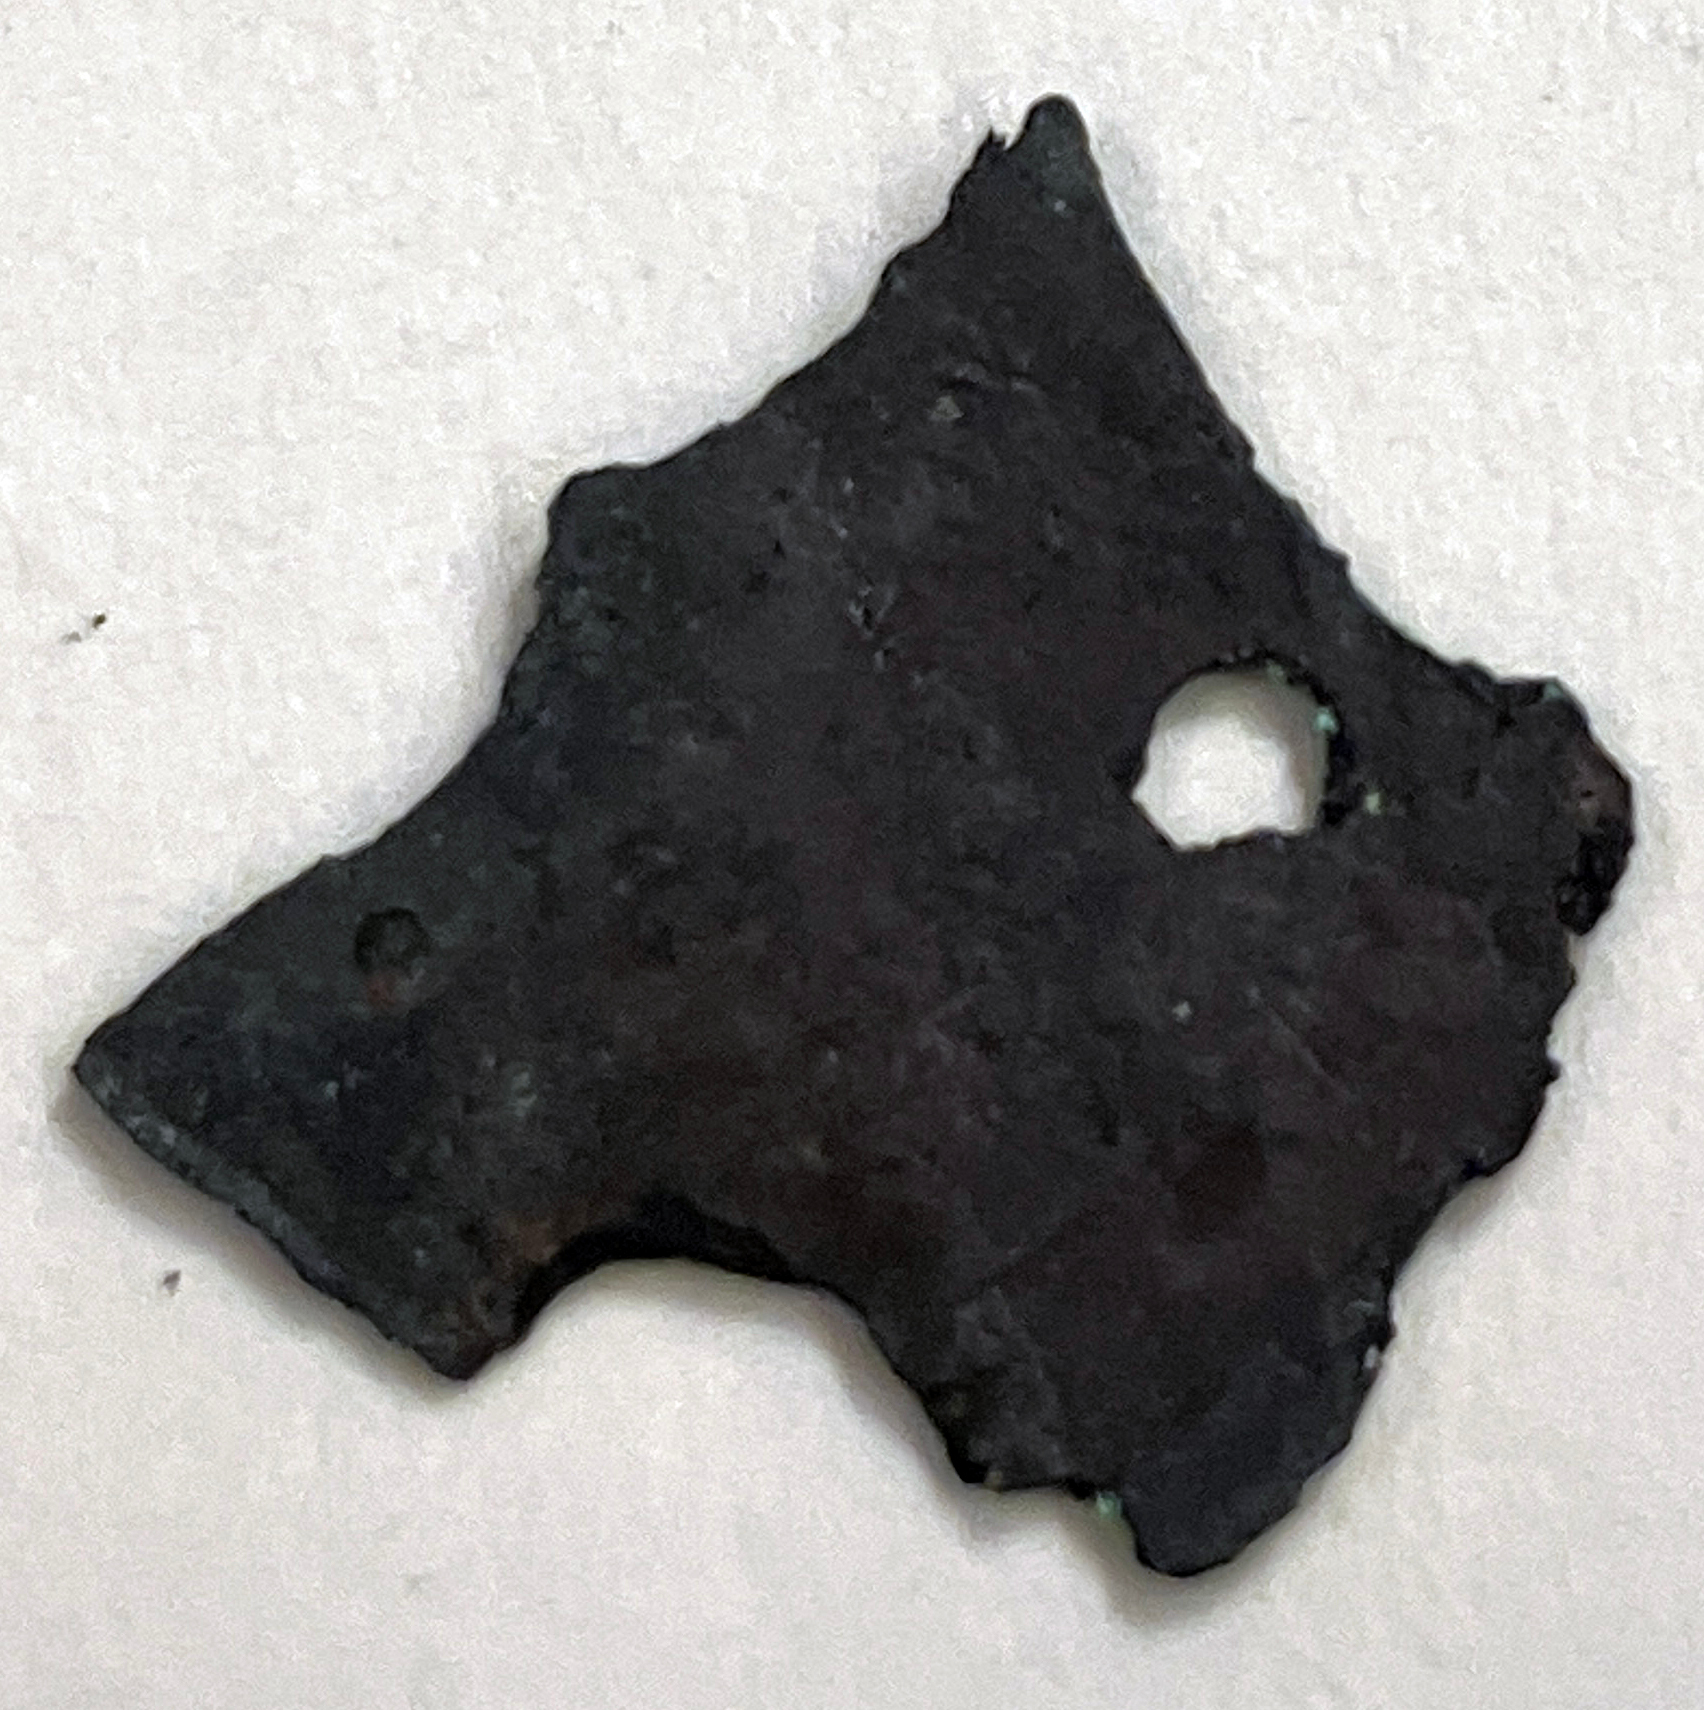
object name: coin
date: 718-814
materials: copper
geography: iran